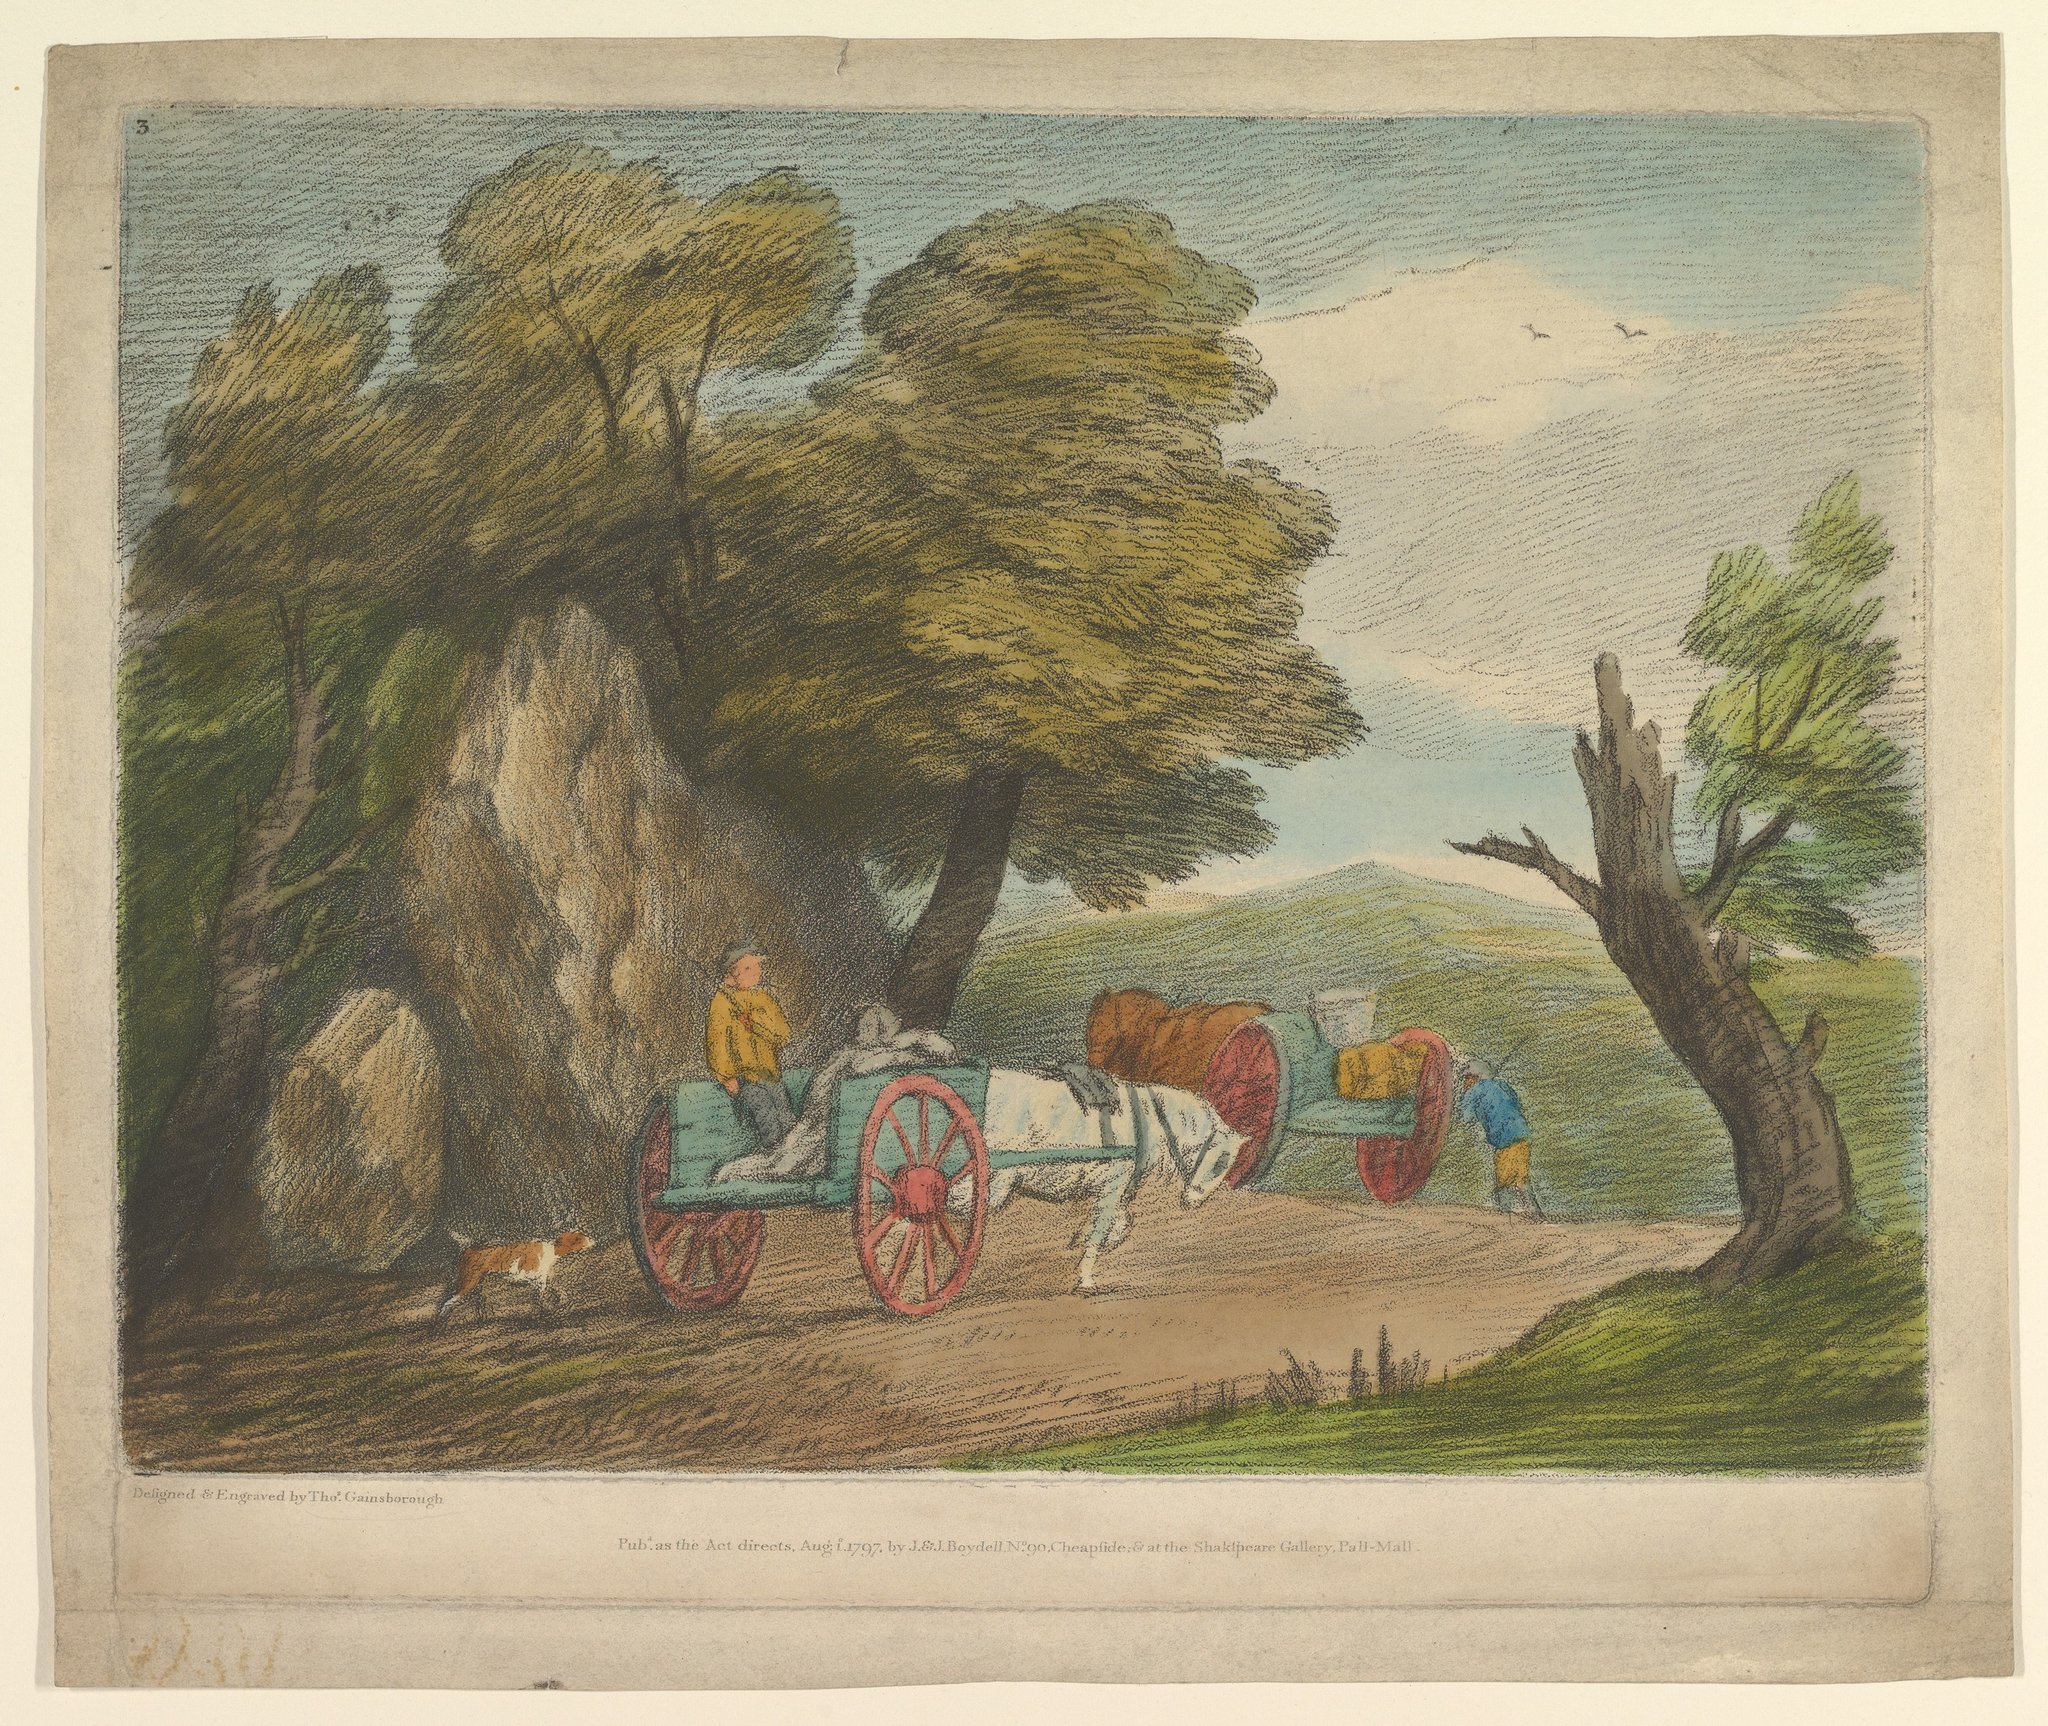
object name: print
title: Wooded Landscape with Two Country Carts and Figures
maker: thomas gainsborough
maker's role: artist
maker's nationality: british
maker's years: 1727-1788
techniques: aquatint, hand coloring, etching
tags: horses,landscapes,carts